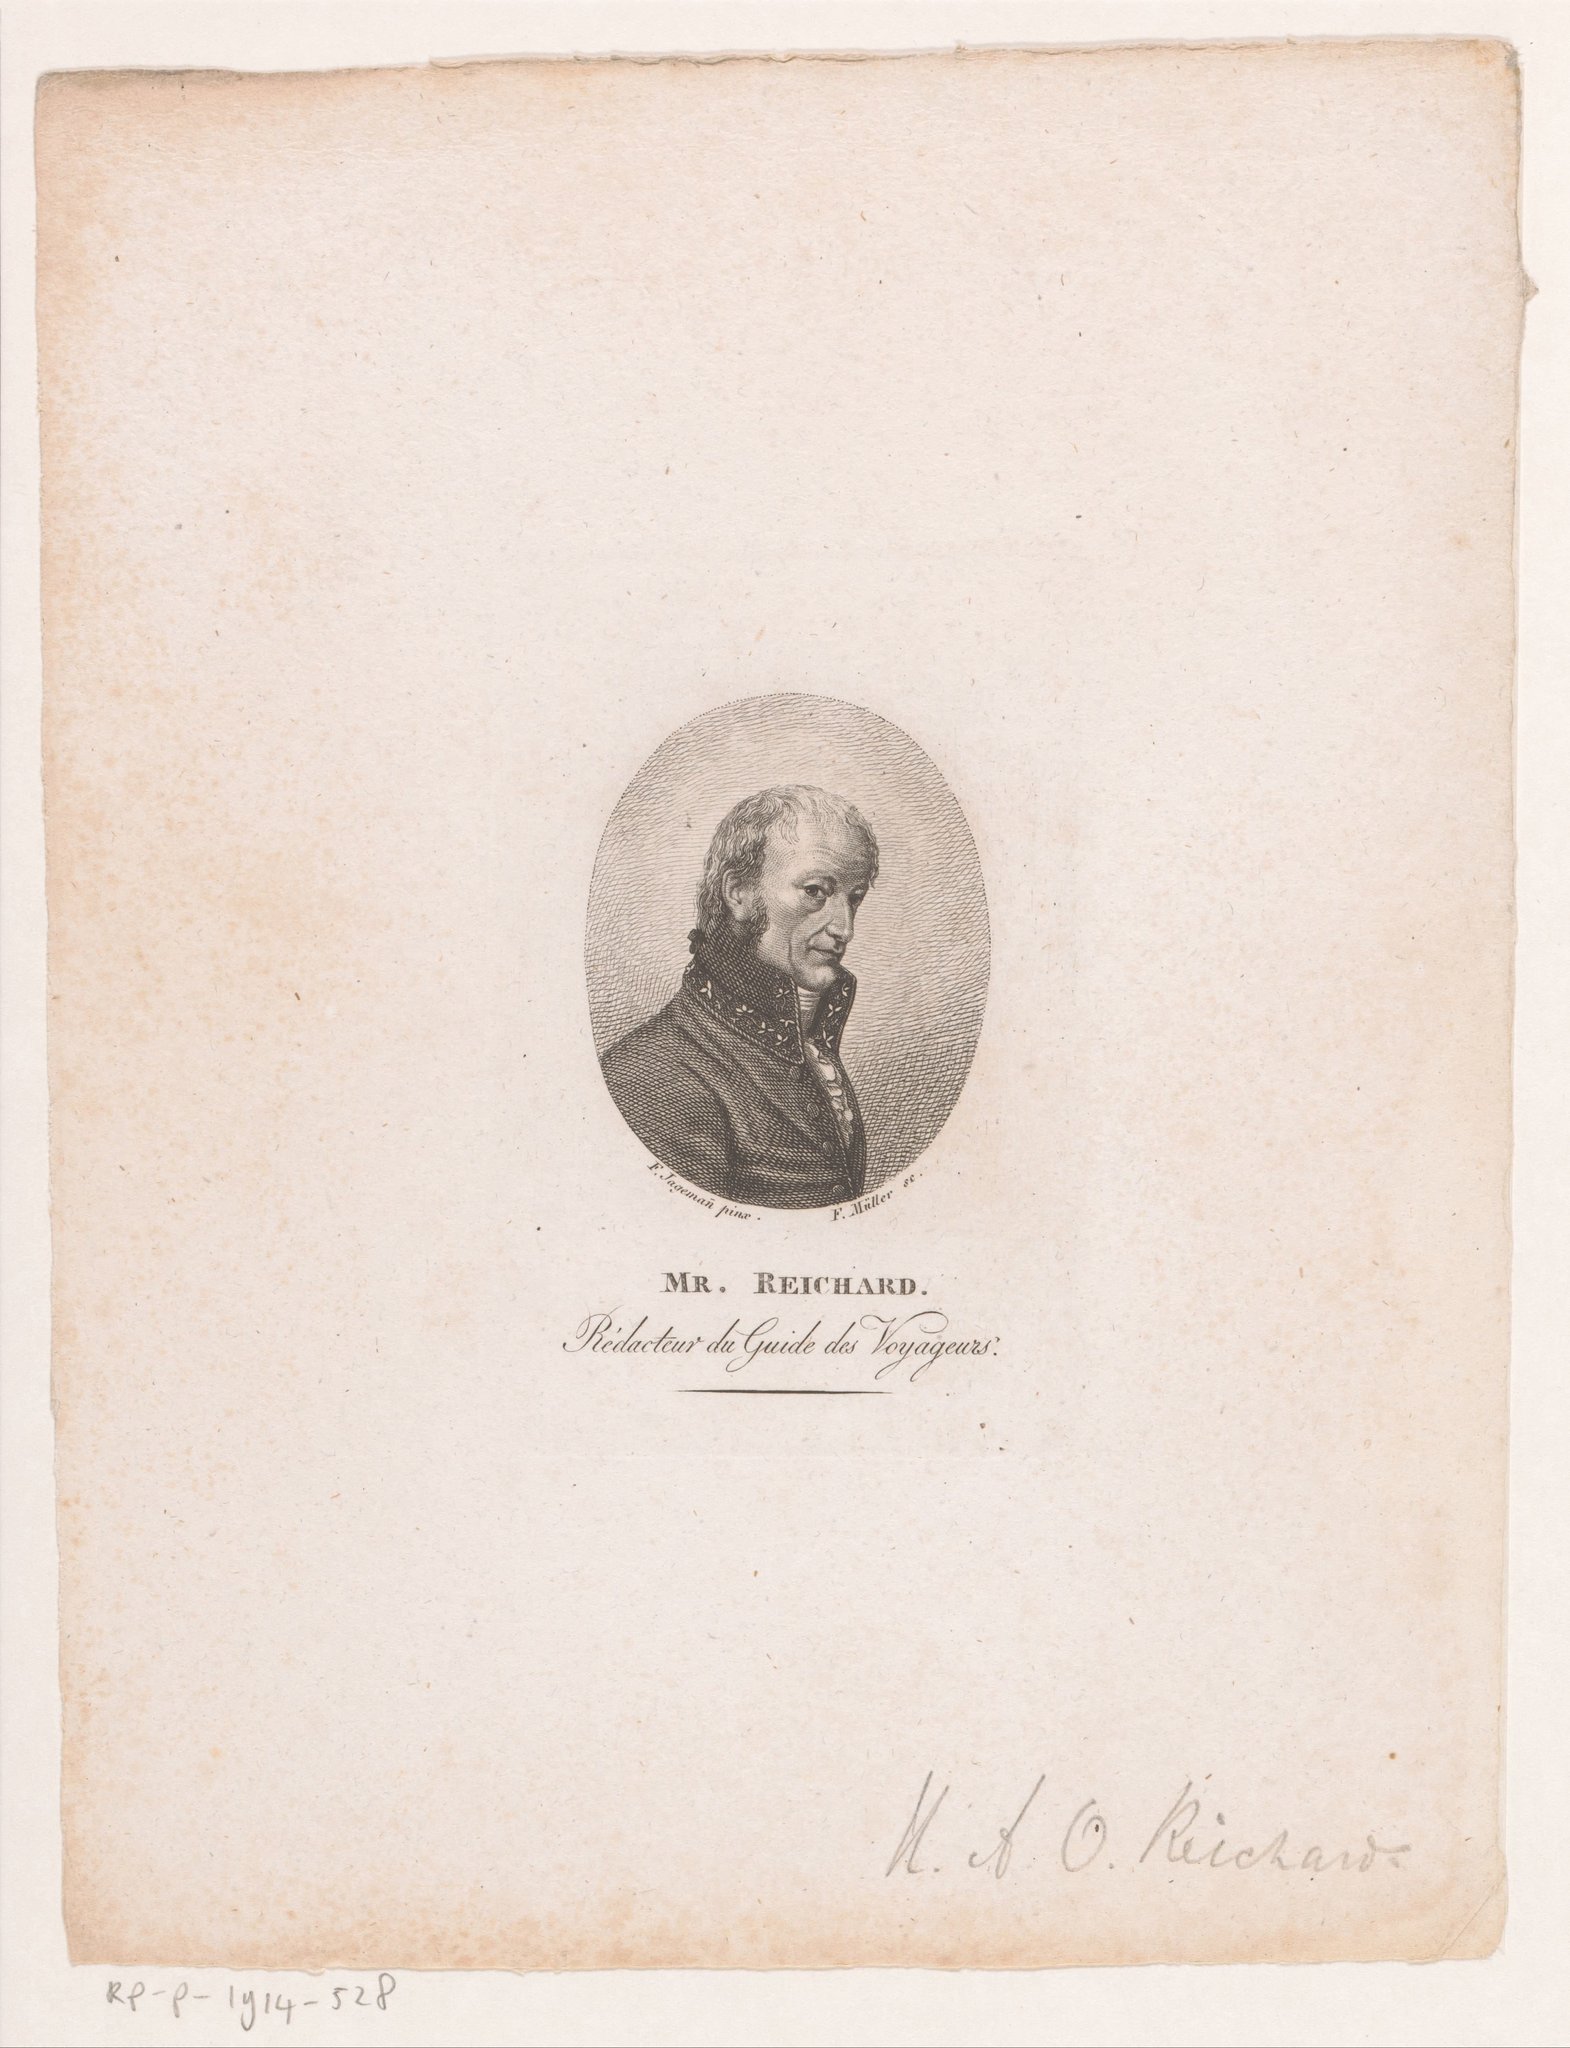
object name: print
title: Portret van Heinrich August Ottokar Reichard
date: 1792-1816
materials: paper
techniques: etching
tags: historical persons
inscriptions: collector's mark: Lugt 2228